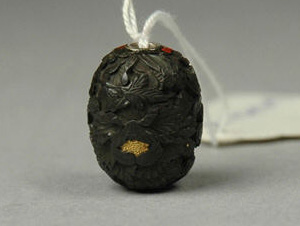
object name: ojime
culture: japanese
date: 1801-1900